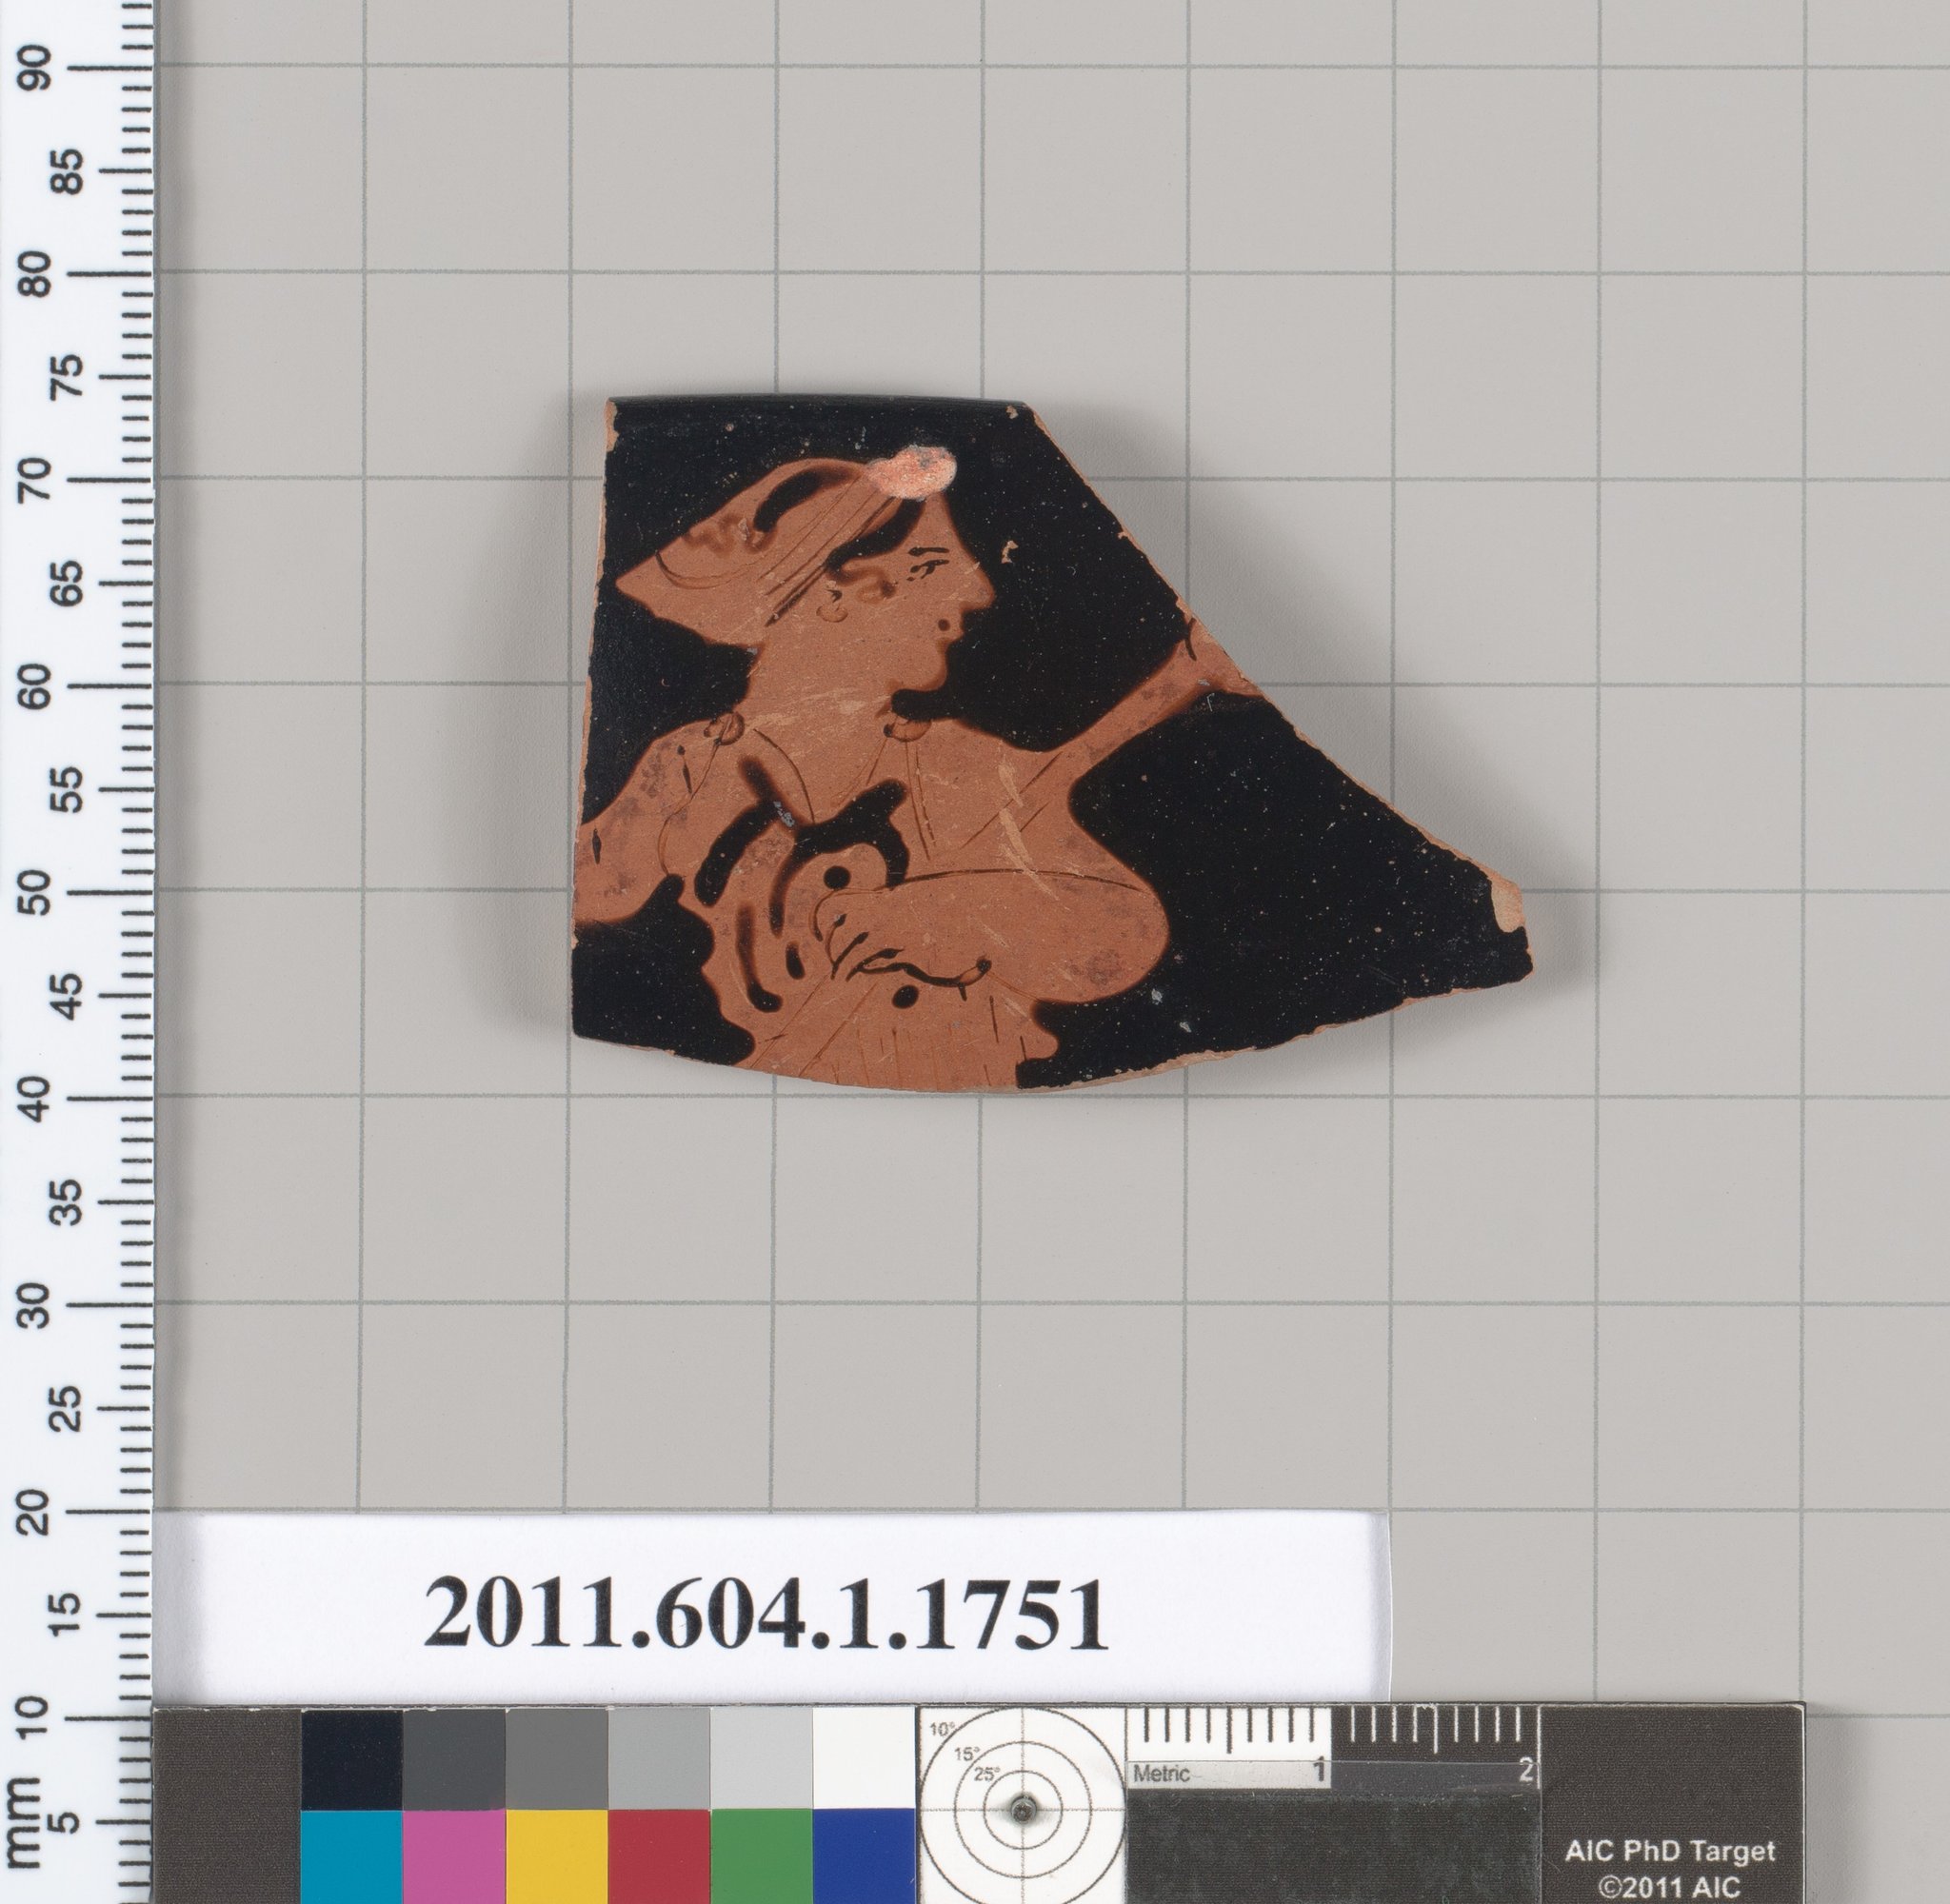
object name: kylix fragment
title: Terracotta rim fragment of a kylix (drinking cup)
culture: greek, attic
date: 467-435 BCE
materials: terracotta